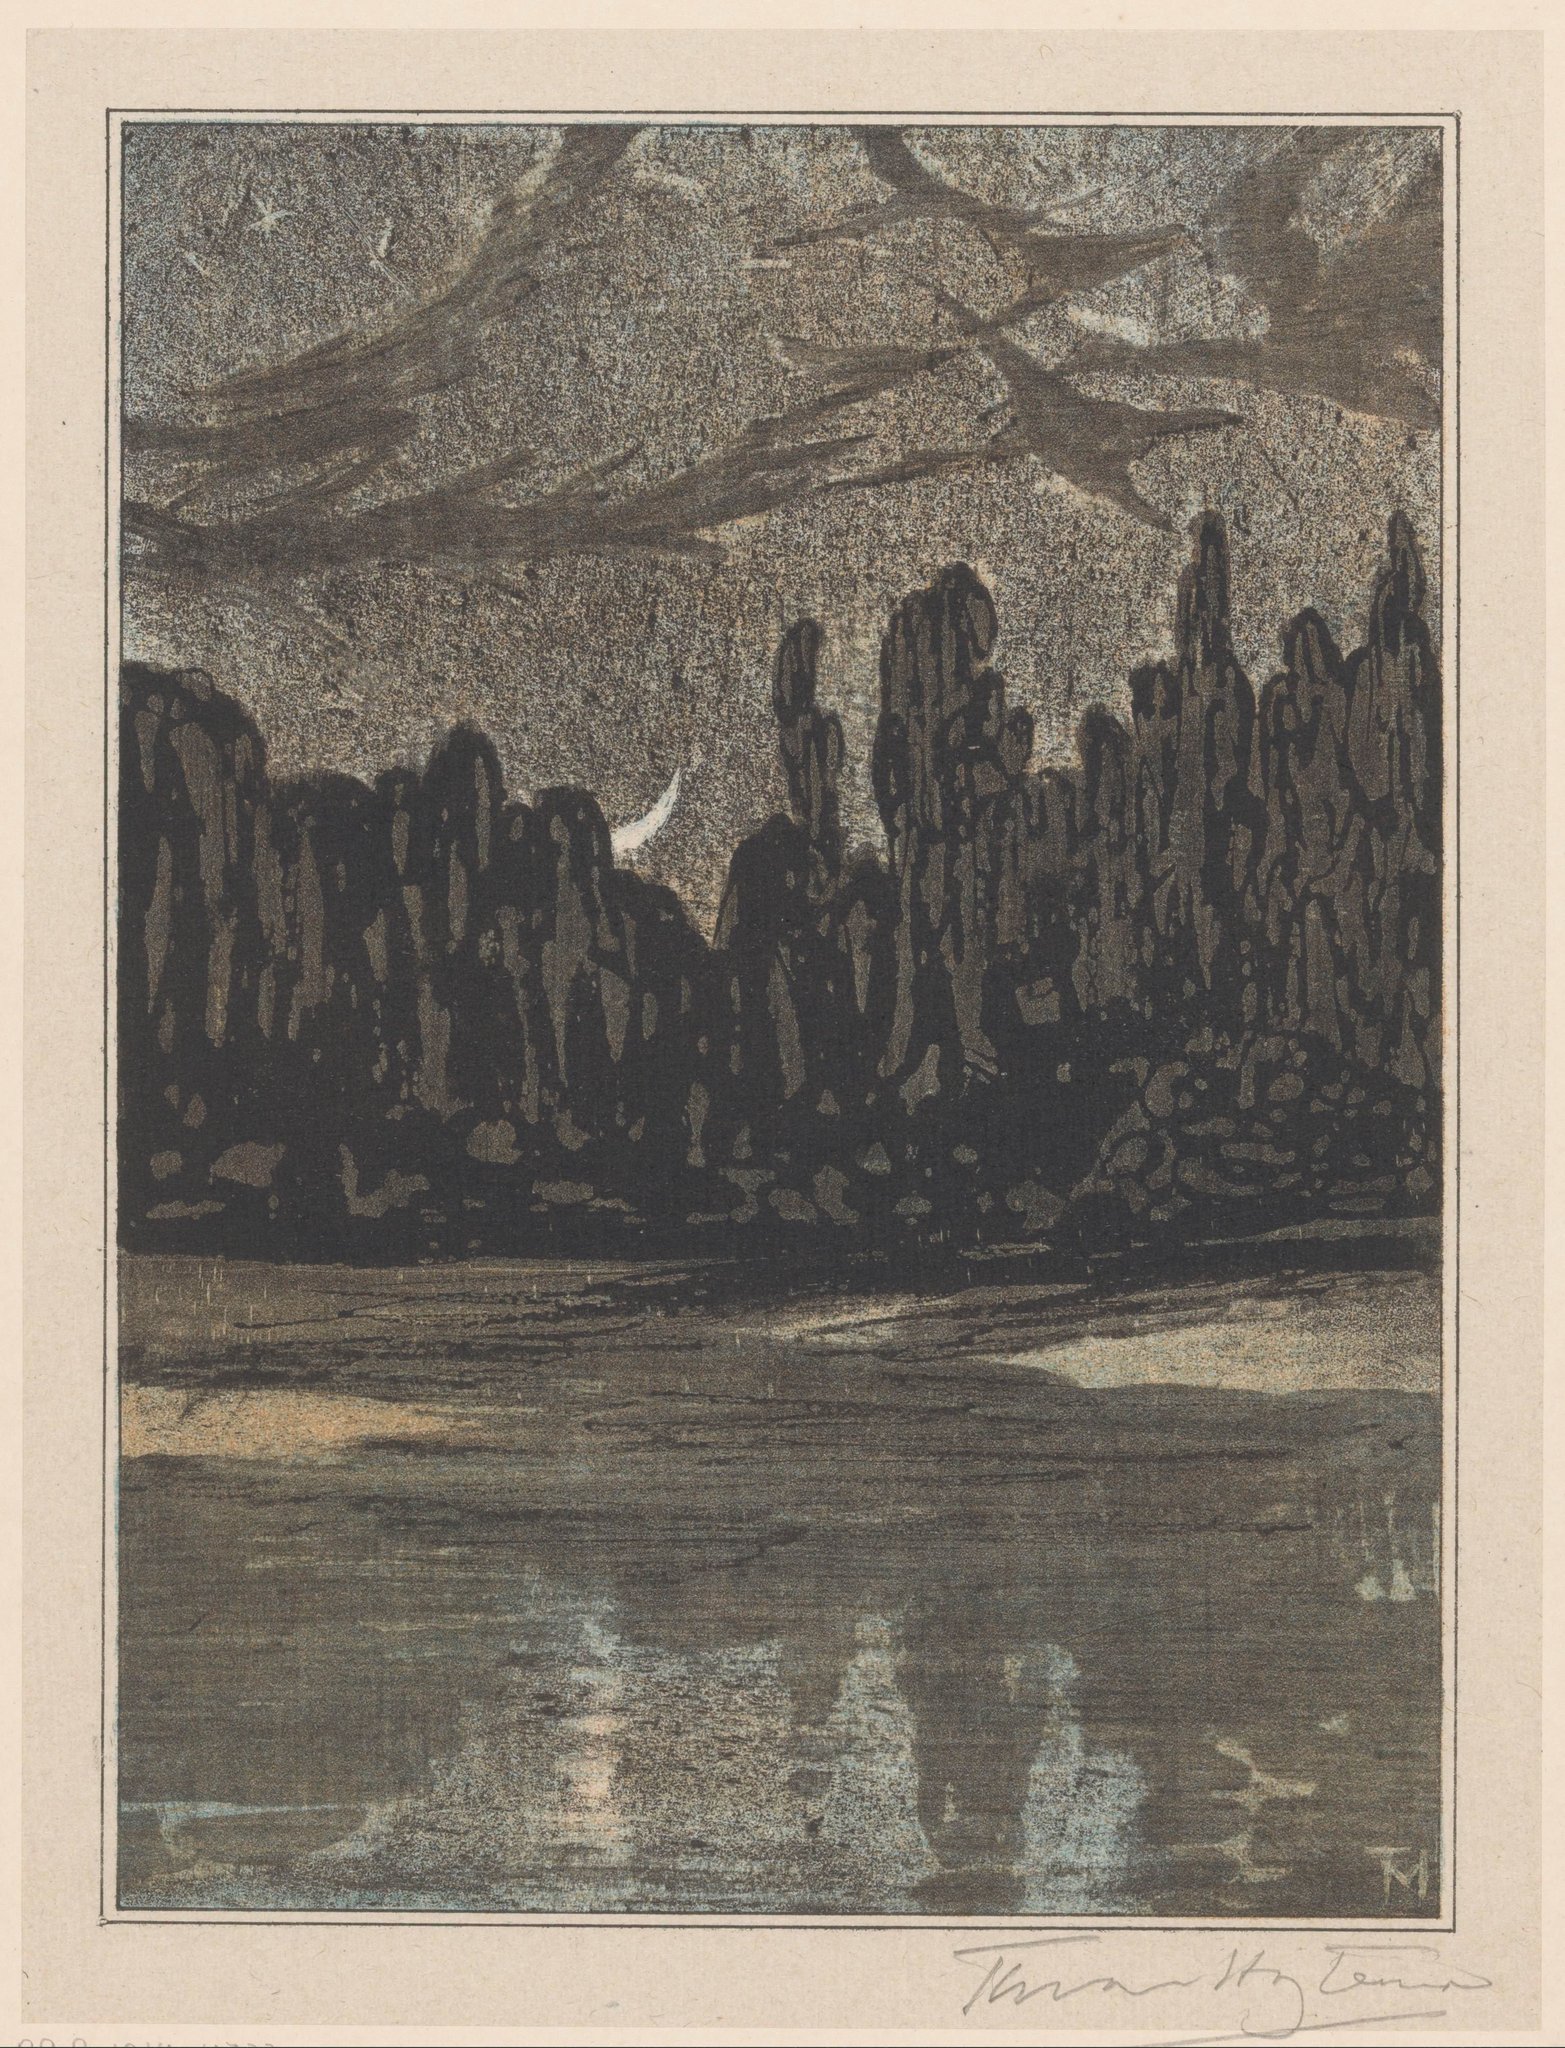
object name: print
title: Nachtelijk landschap met trekvogels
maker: theo van hoytema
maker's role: draughtsman, painter, print maker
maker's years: 1863-1917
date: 1878-1907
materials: paper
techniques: lithograph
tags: waxing moon, i.e. facing this way: ), birds, night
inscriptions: collector's mark: Lugt 2233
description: Trekvogels vliegen boven een rotsachtig landschap en water.